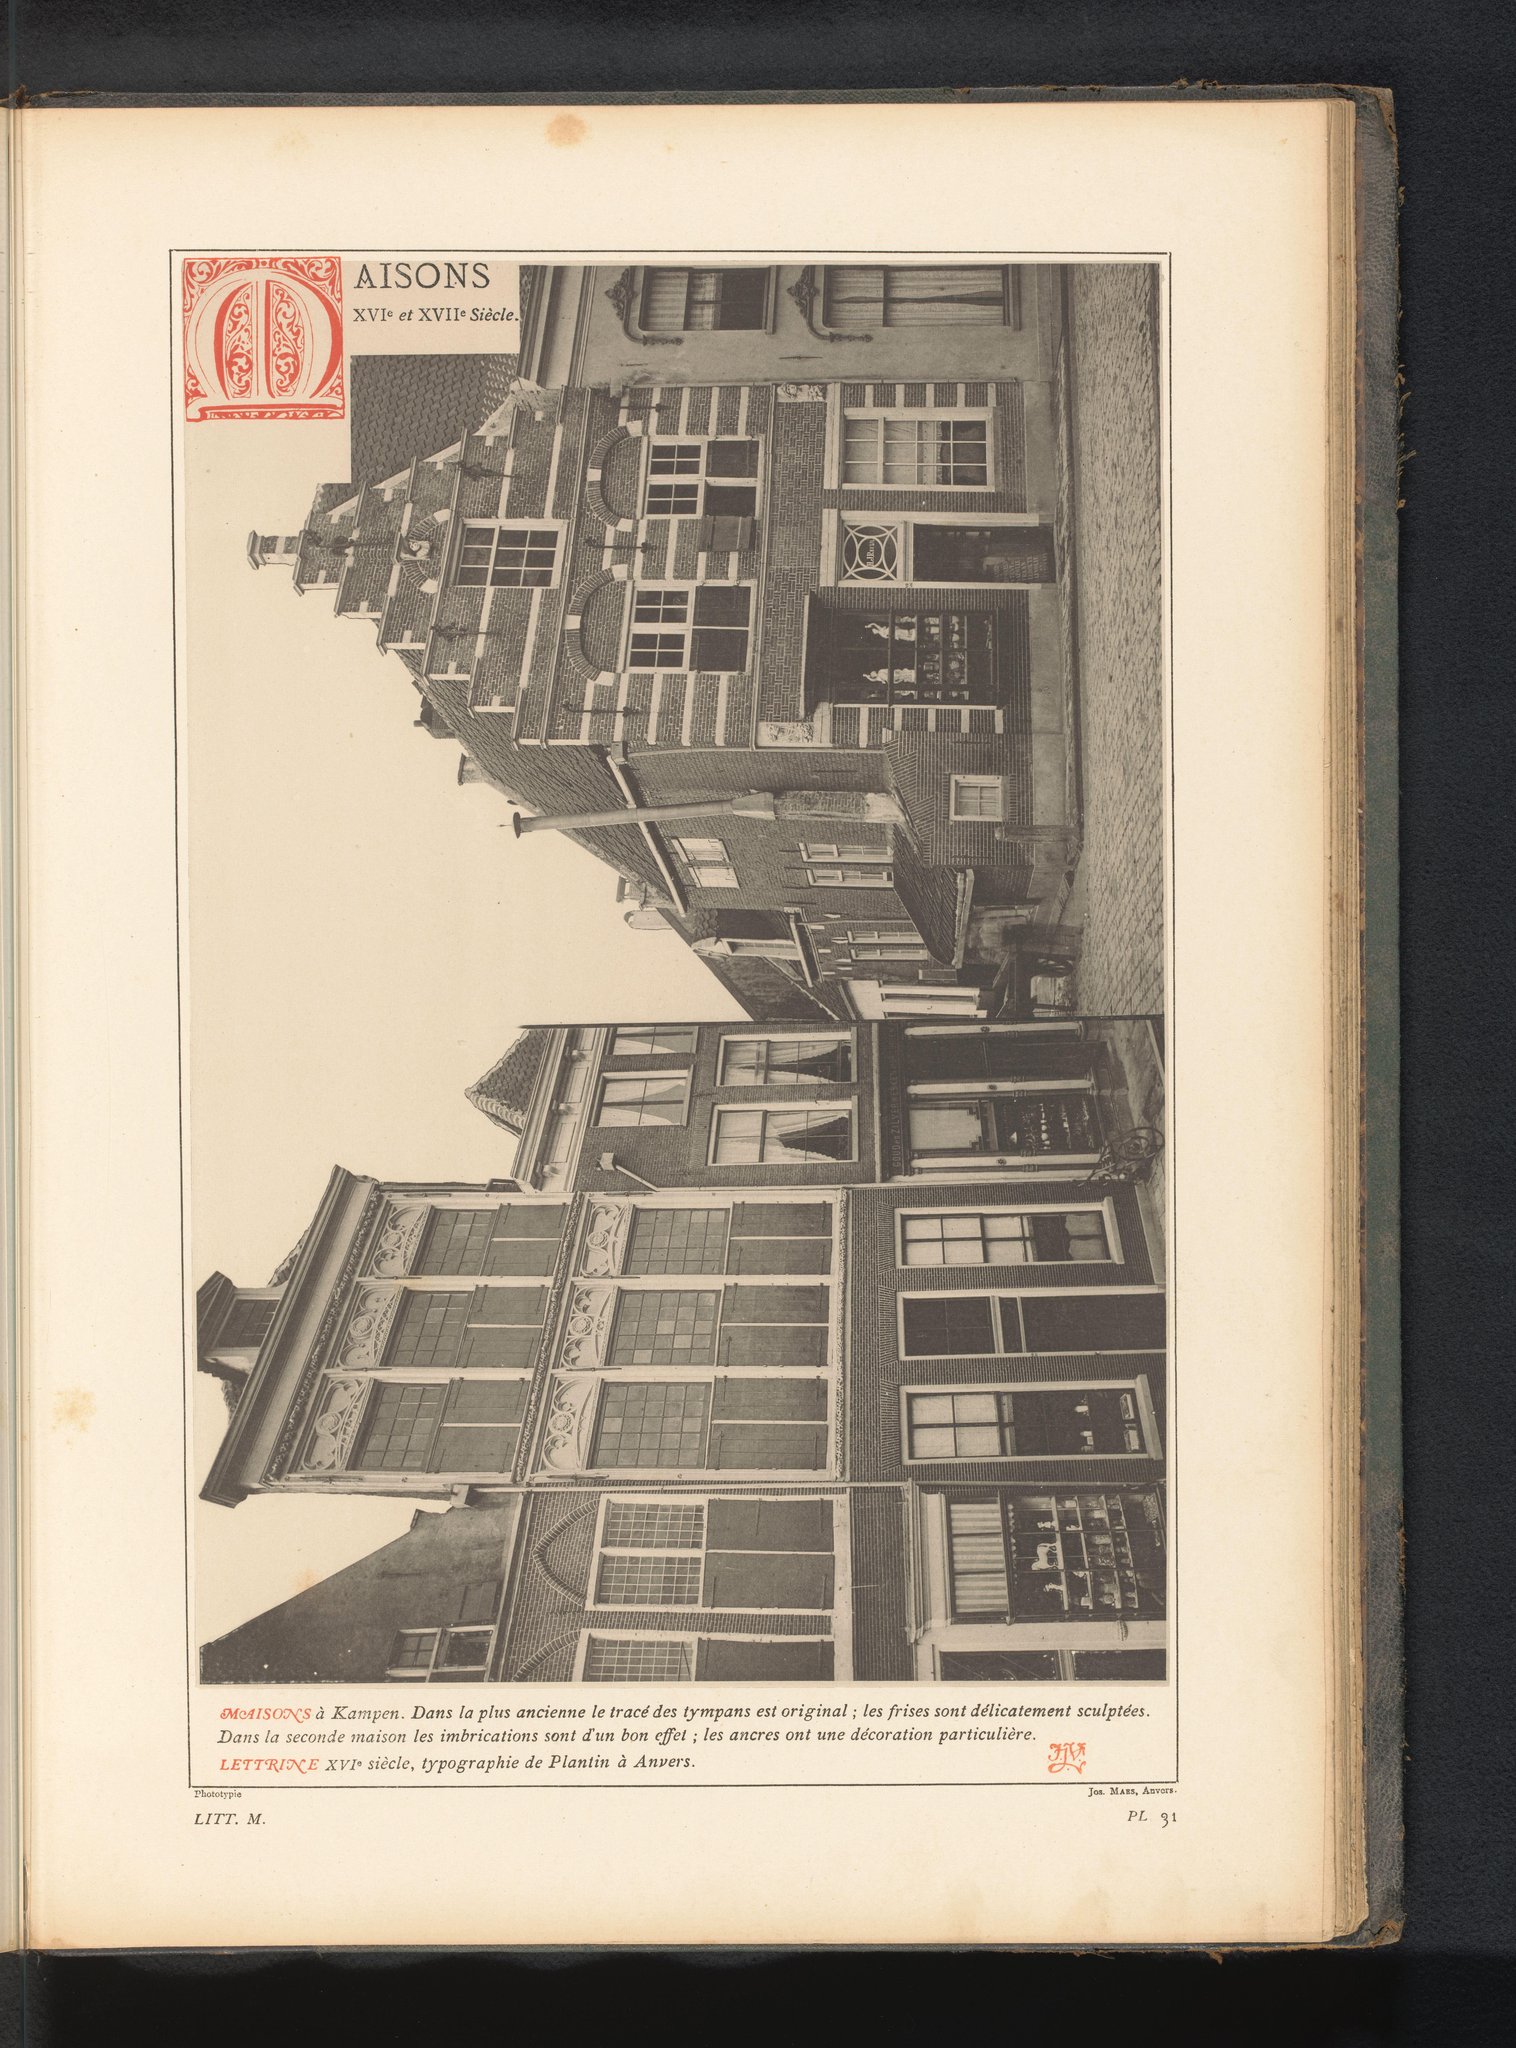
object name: page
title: Gezicht op een rij huizen in Kampen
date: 1875-1880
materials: paper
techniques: photograph, photolithography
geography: antwerp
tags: the usual house or row of houses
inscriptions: inscription: ‘MAISONS à Kampen (...)’, inscription: ‘LITT. M. - PL. 31’, monogram: ‘JJvY’